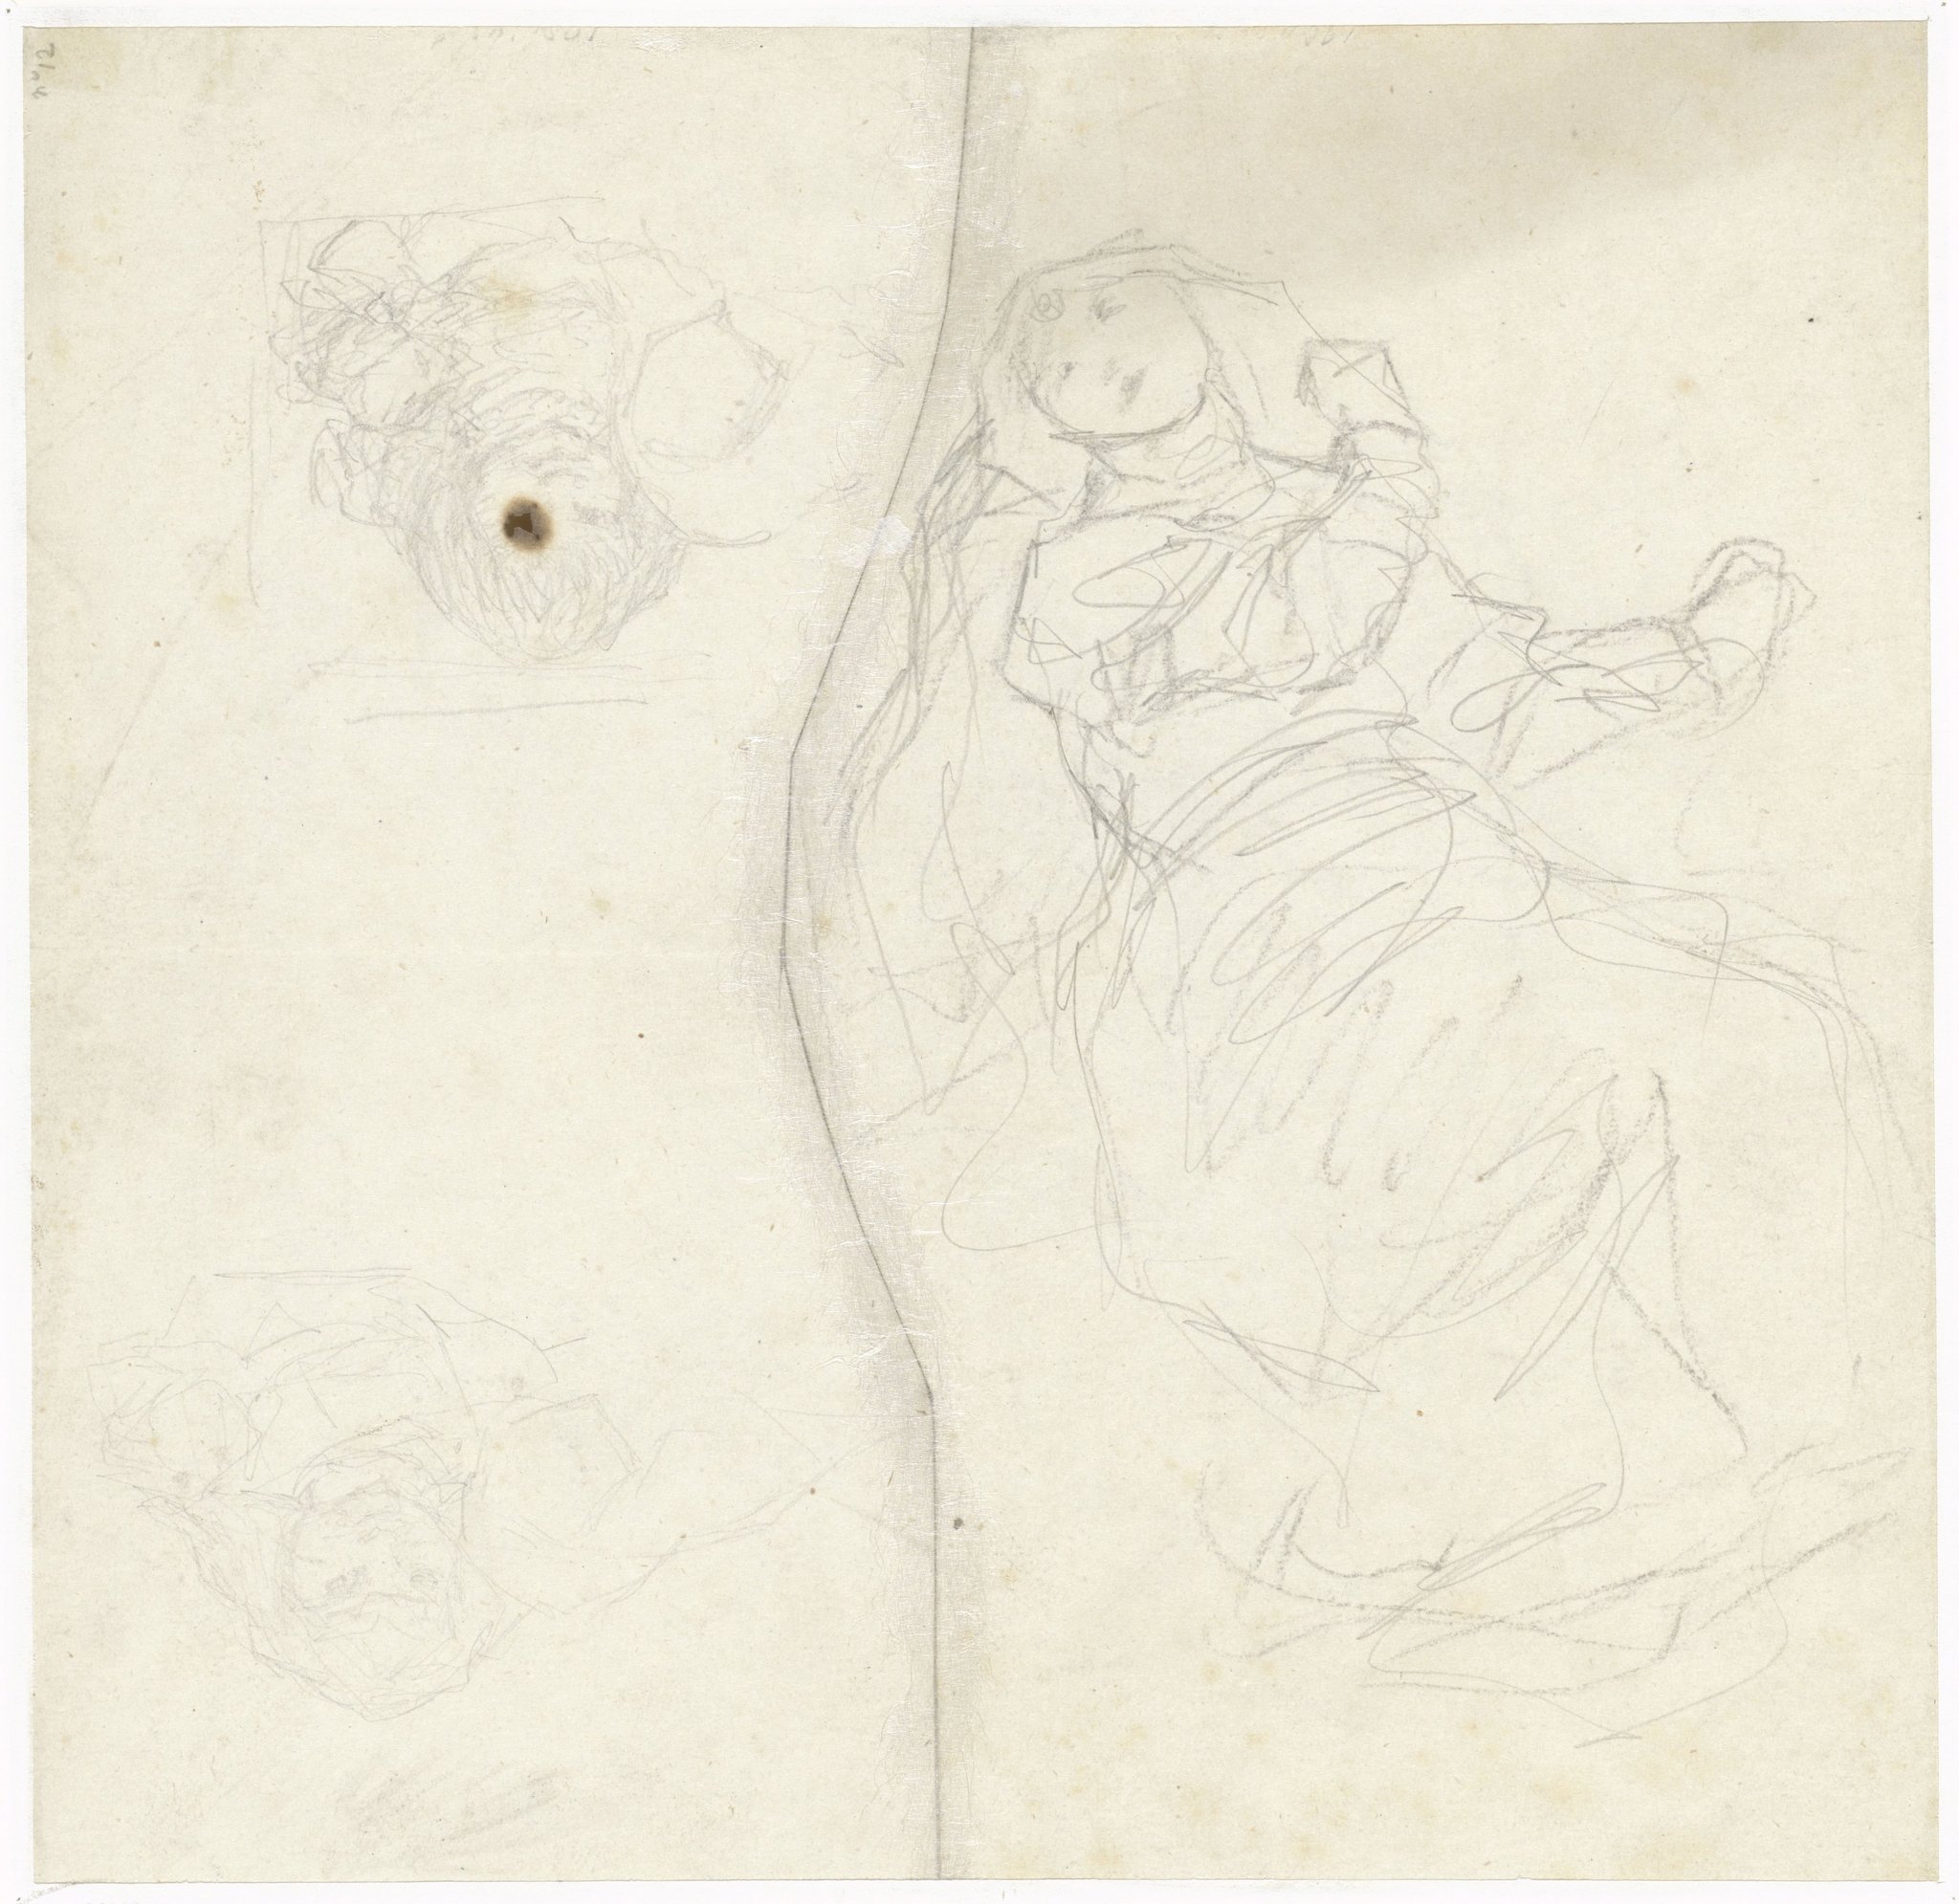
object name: drawing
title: Schets van een vrouw met vlinders en twee studies van een meisje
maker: matthijs maris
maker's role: draughtsman, painter, print maker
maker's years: 1839-1917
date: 1849-1917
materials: paper, pencil